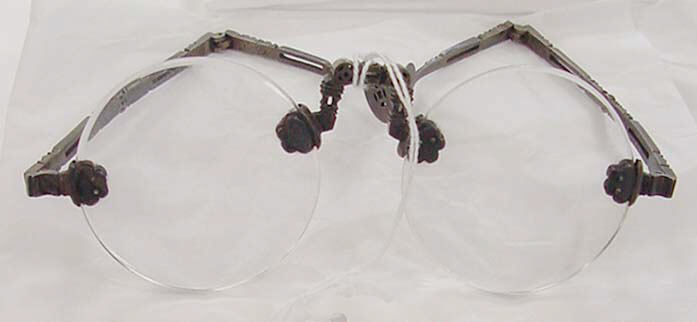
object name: spectacle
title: Spectacles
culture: chinese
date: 1801-1900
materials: glass, metal